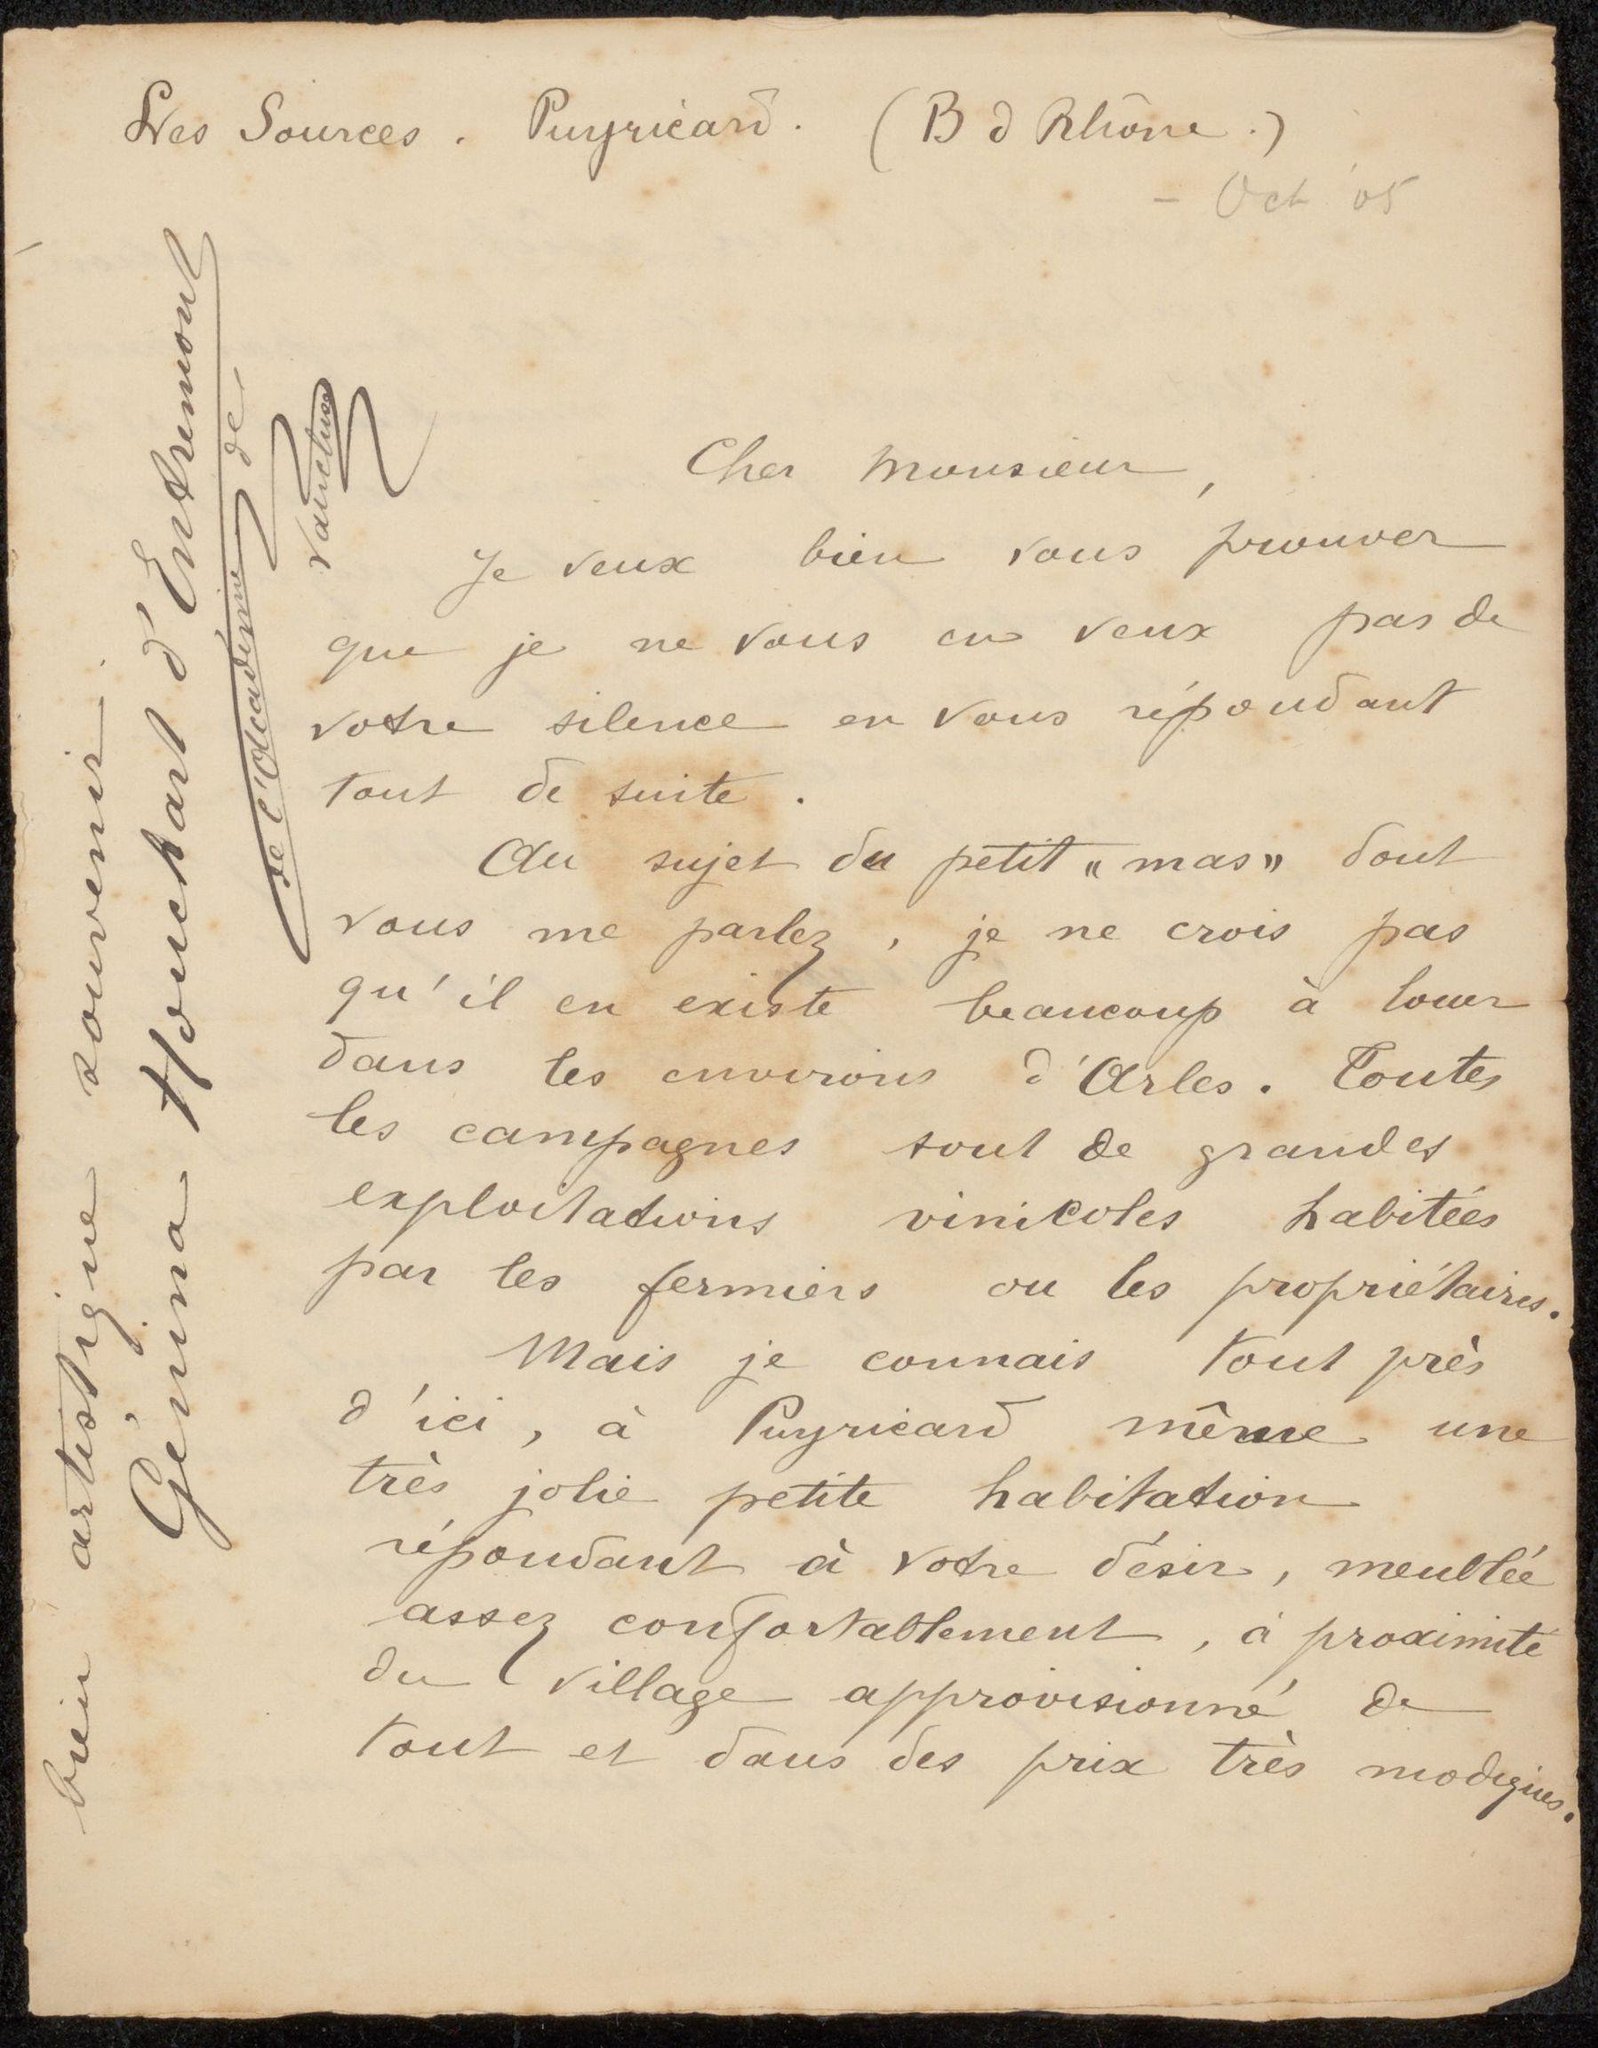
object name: letter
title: Brief aan Philip Zilcken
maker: eugénie clapier-houchart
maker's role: dichter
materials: ink, paper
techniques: pen, writing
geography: puyricard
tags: maria biermé, the hague, draughtsman, philip zilcken, literature ~ arts, money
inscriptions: seal, collector's mark: ‘RPK’